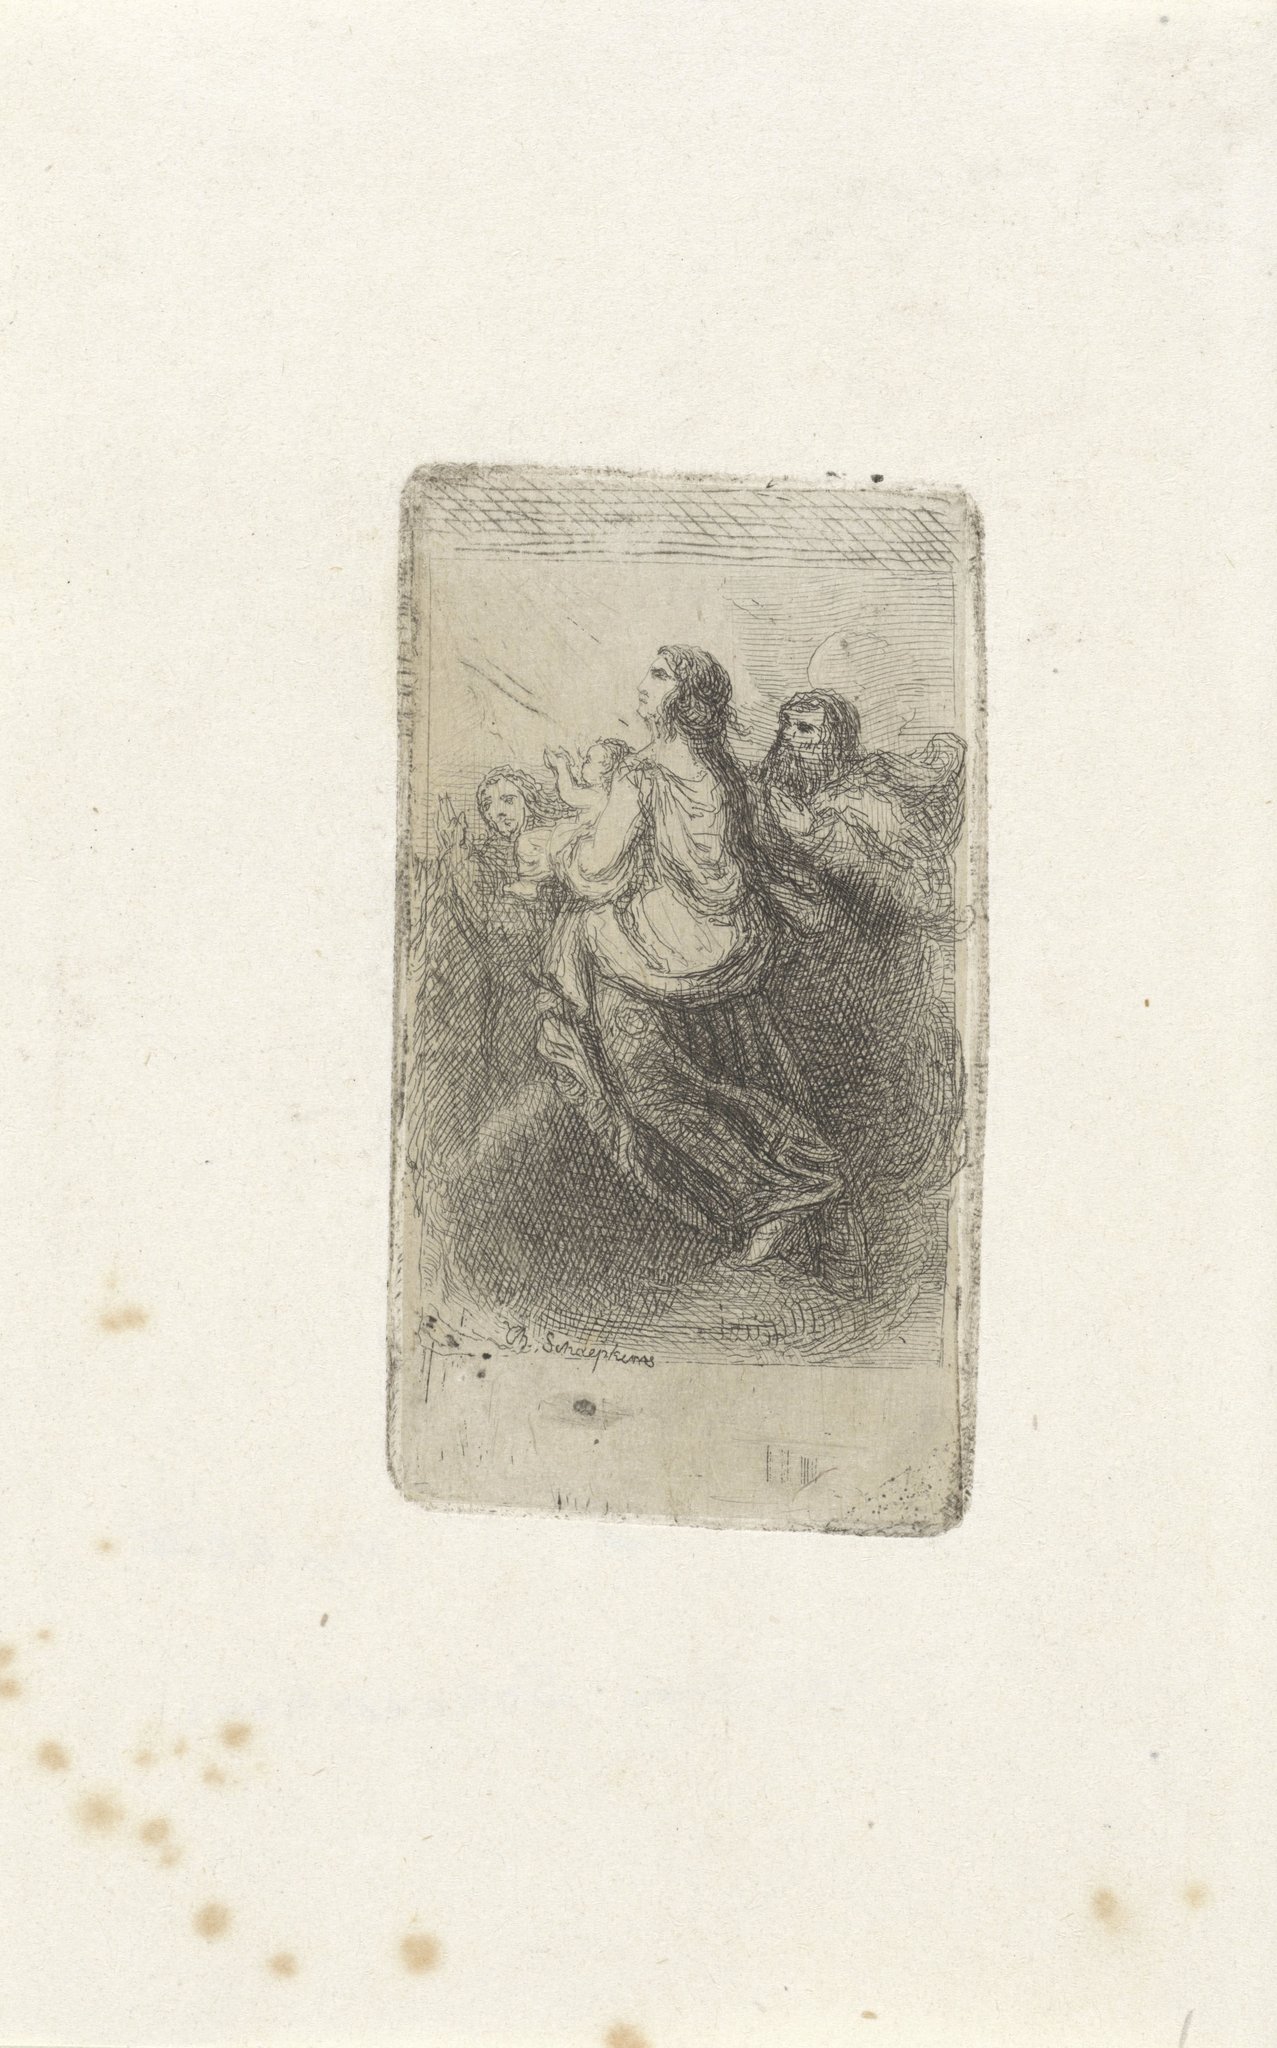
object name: print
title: Oude man en vrouw met kind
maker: theodoor schaepkens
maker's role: draughtsman, print maker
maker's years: 1810-1883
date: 1825-1883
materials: paper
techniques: etching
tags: holy family, and derived representations, mother and baby or young child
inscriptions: collector's mark: Lugt 2228